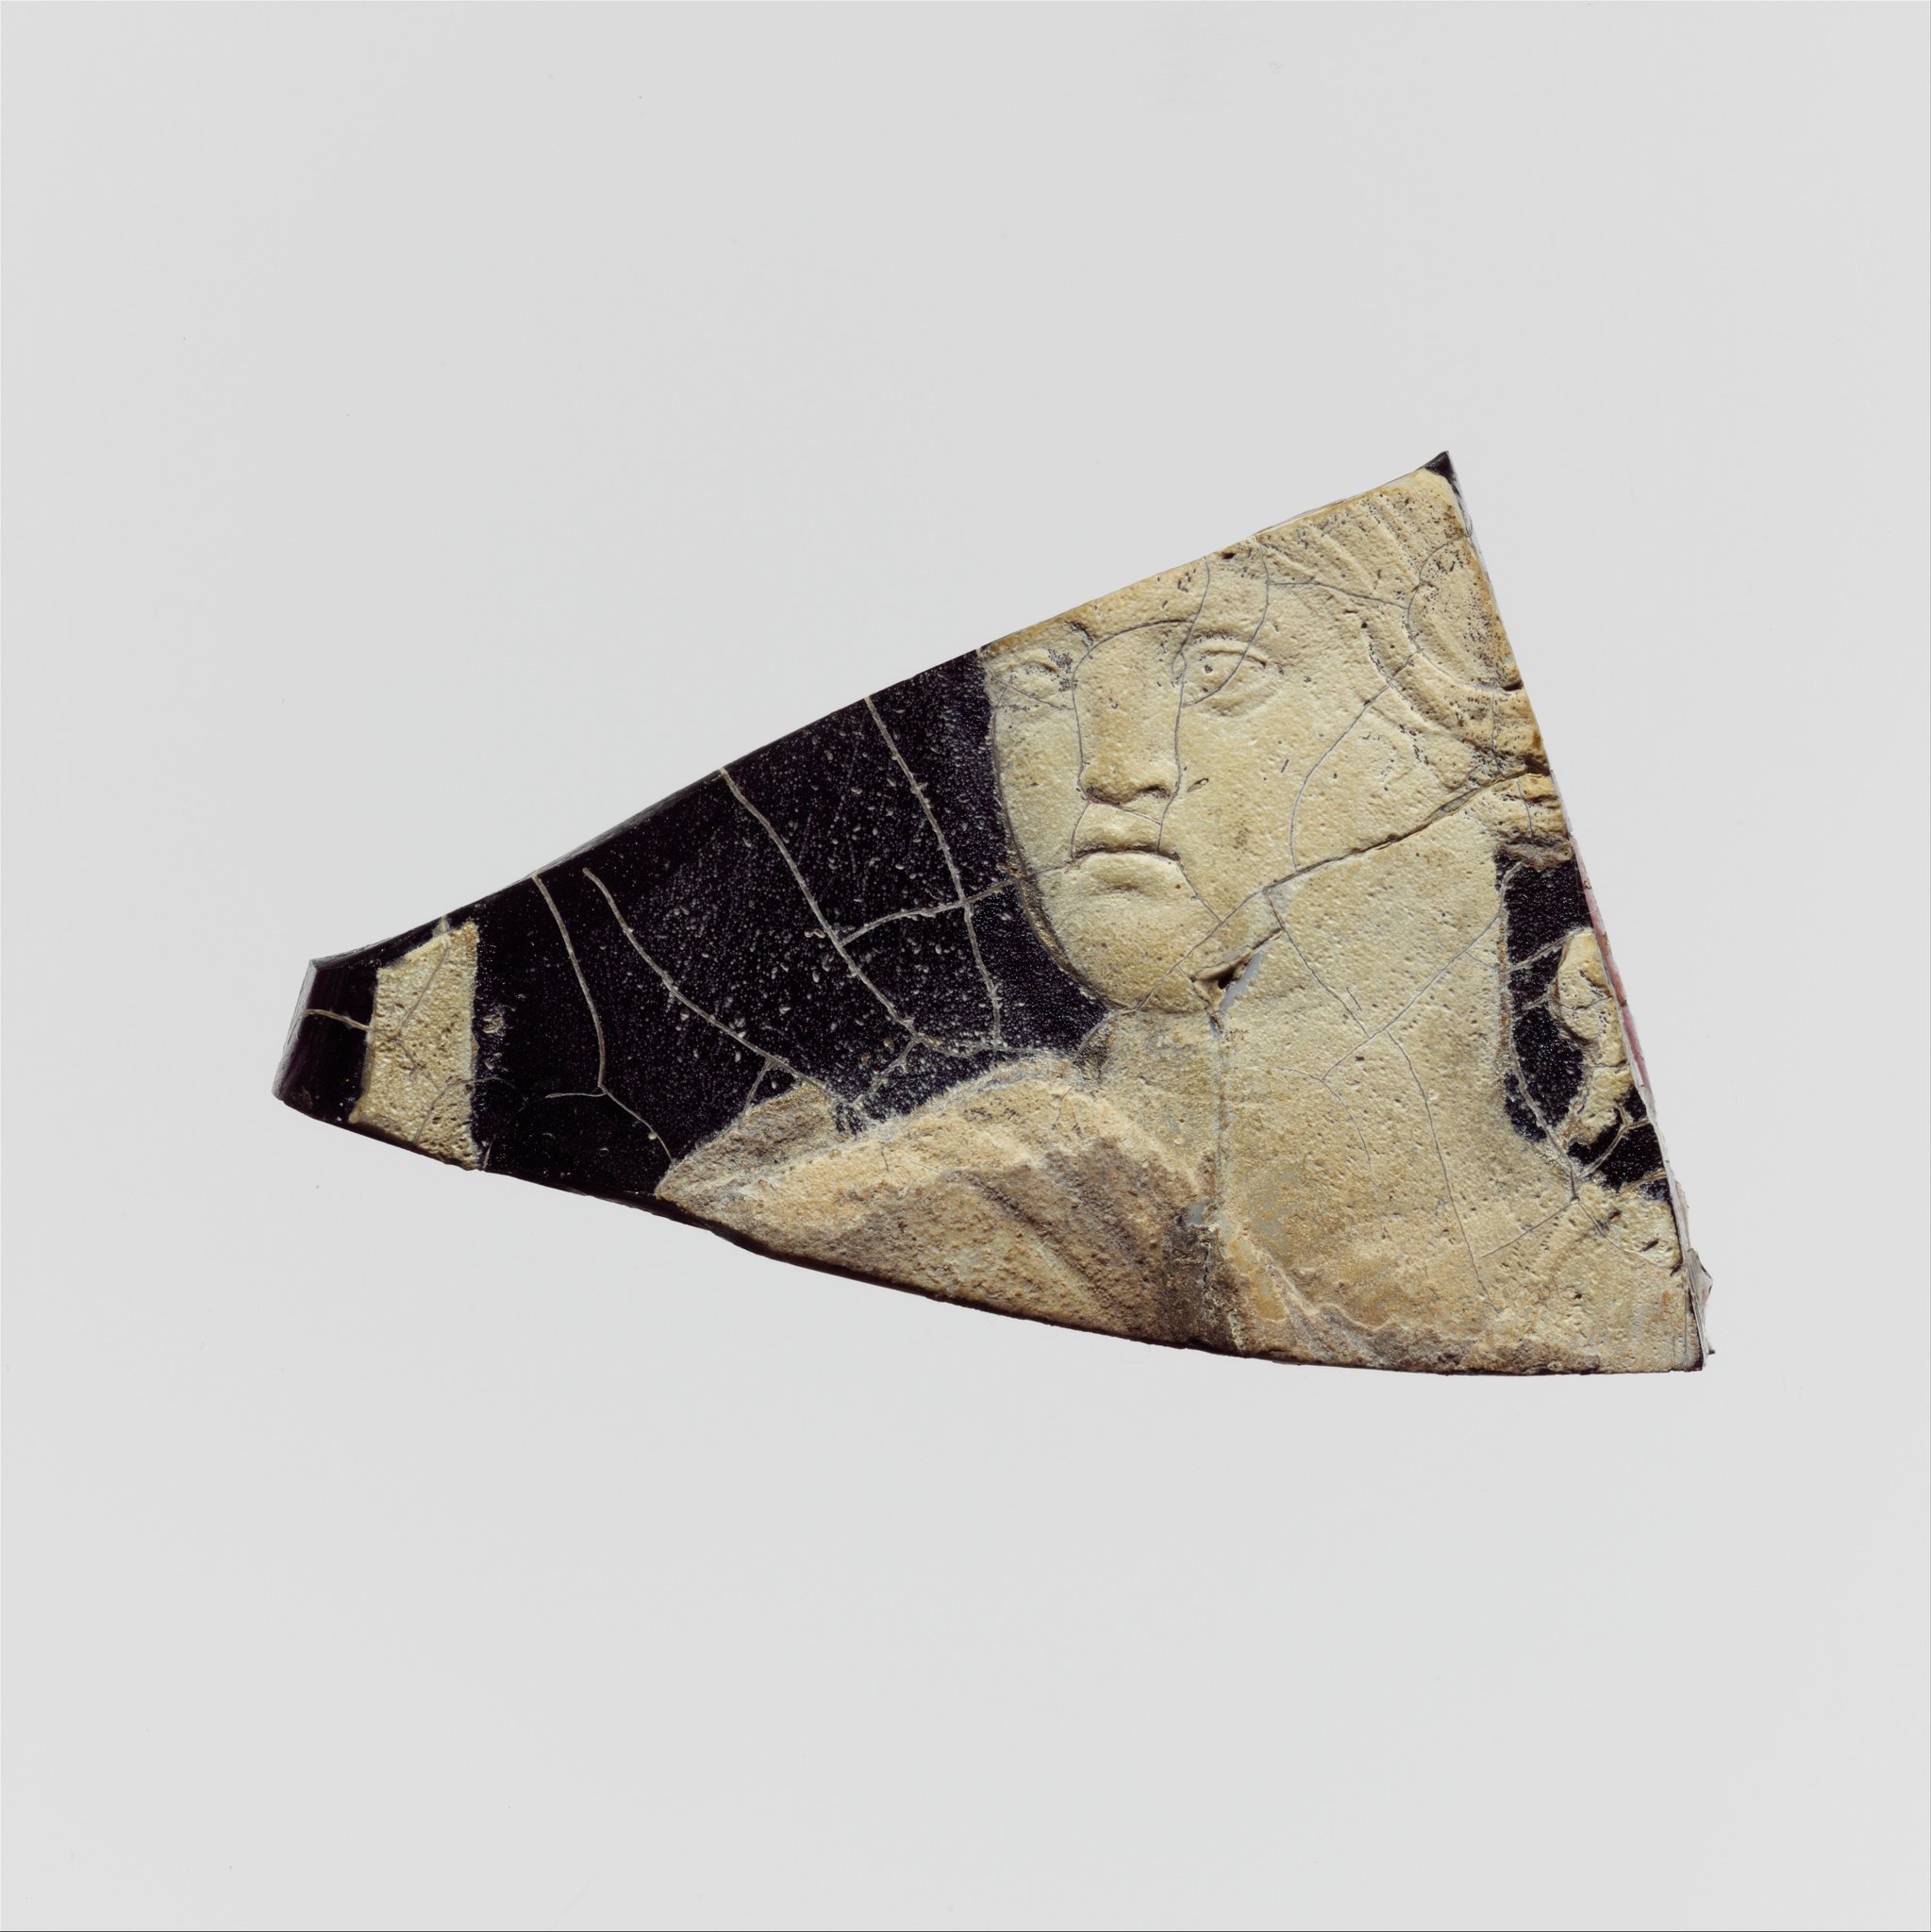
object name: cameo plaque, fragment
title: Glass cameo plaque fragment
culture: roman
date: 1-100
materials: glass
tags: women